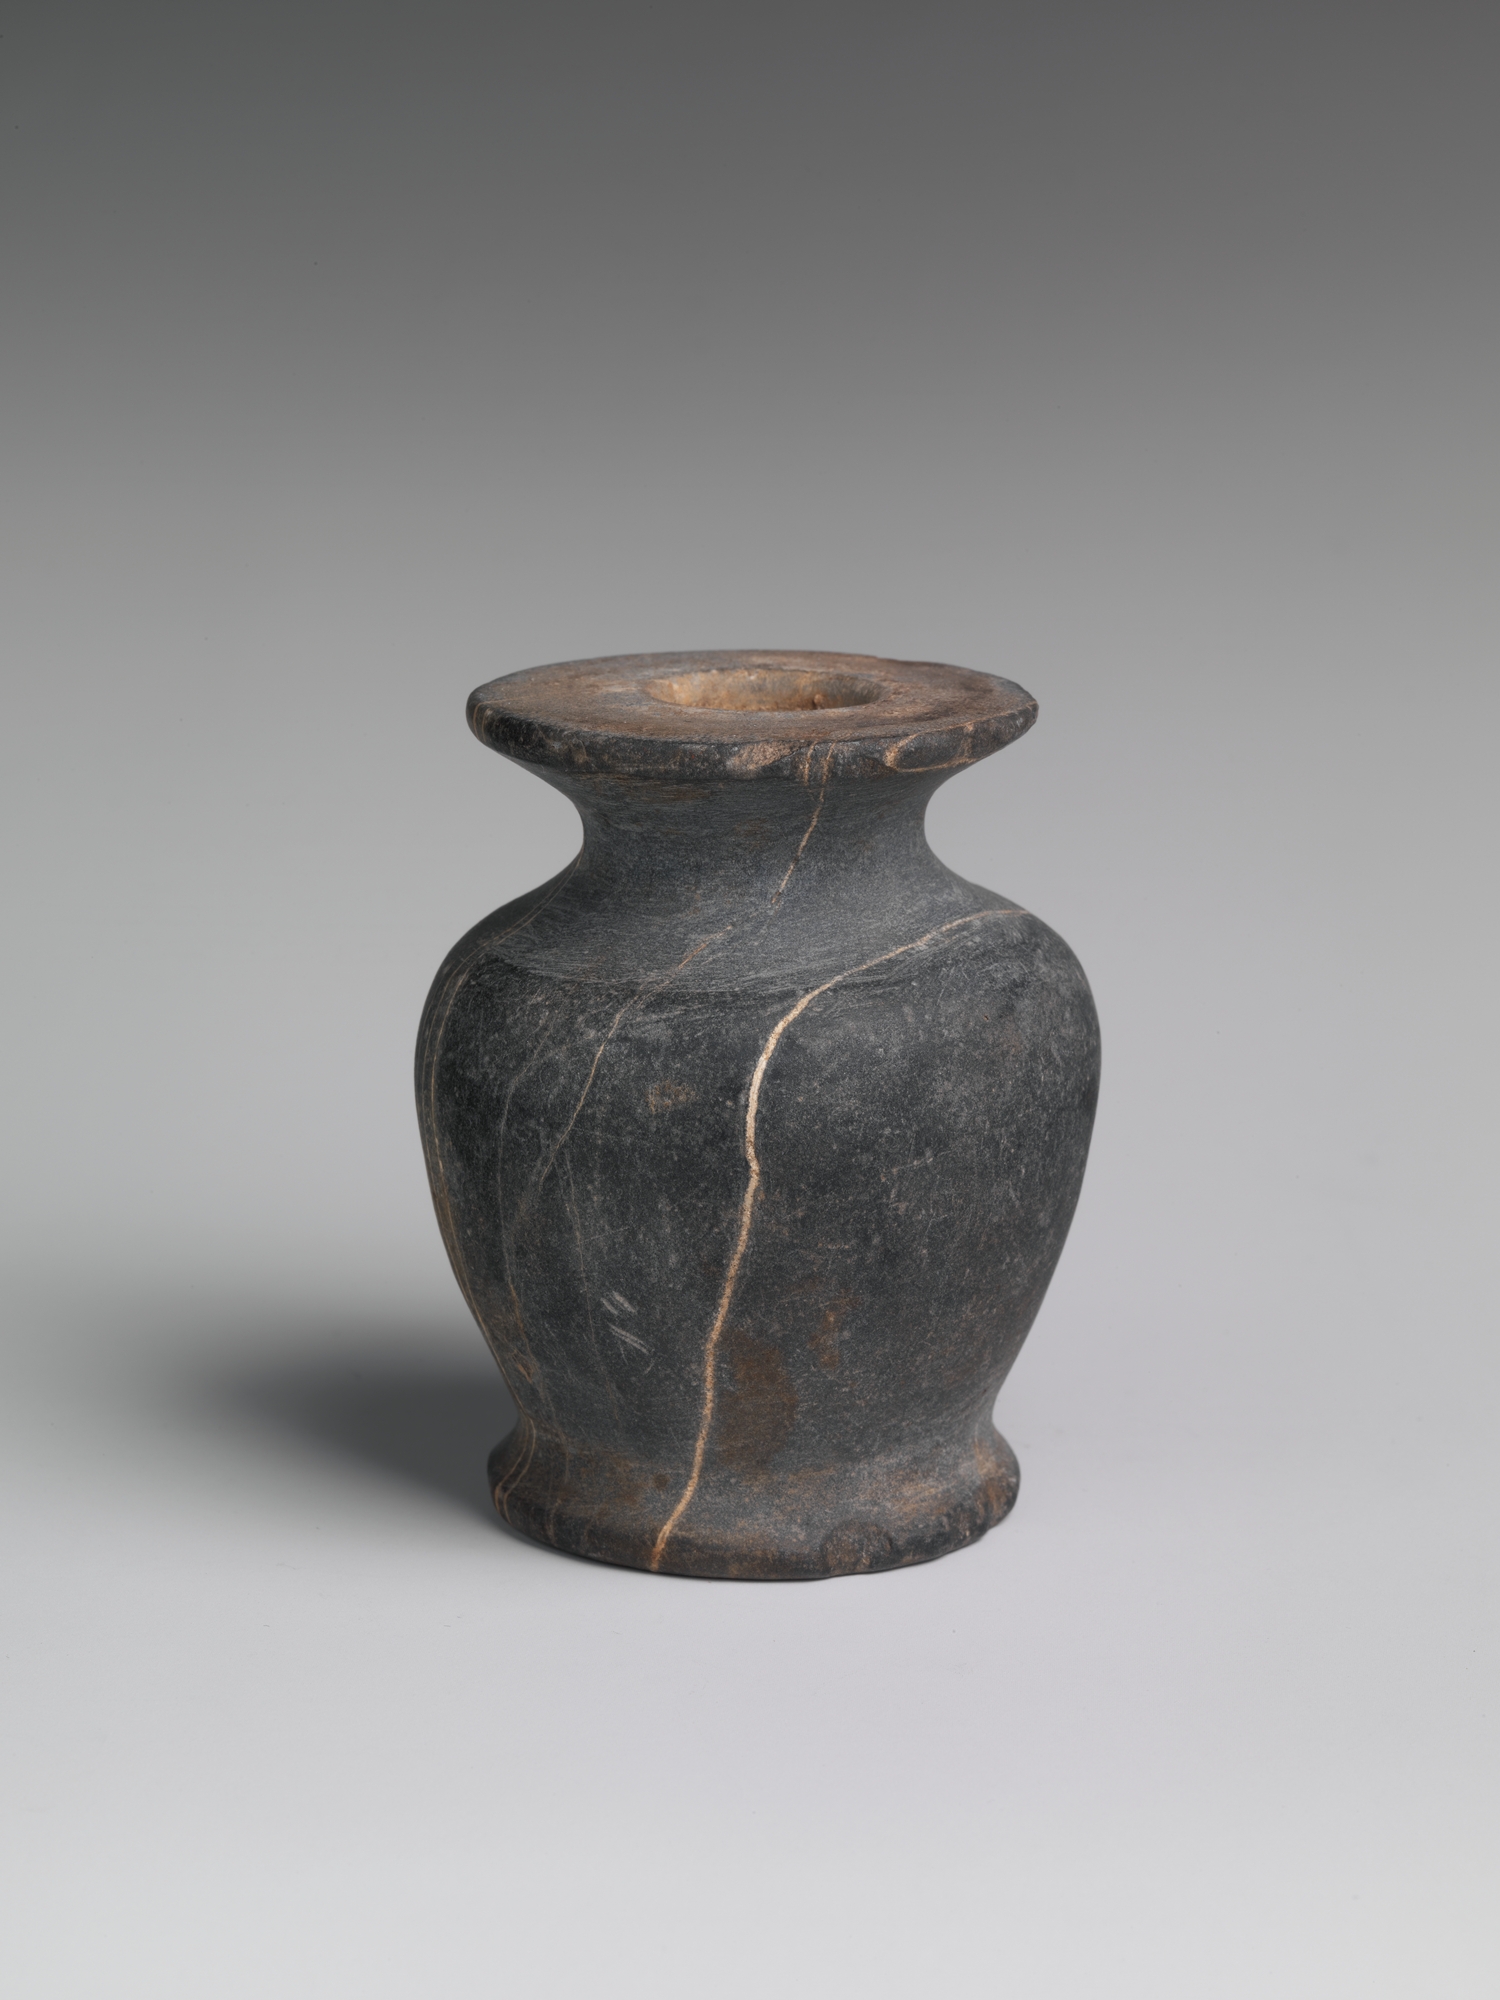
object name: kohl jar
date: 1635-1458 BCE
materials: stone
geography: egypt